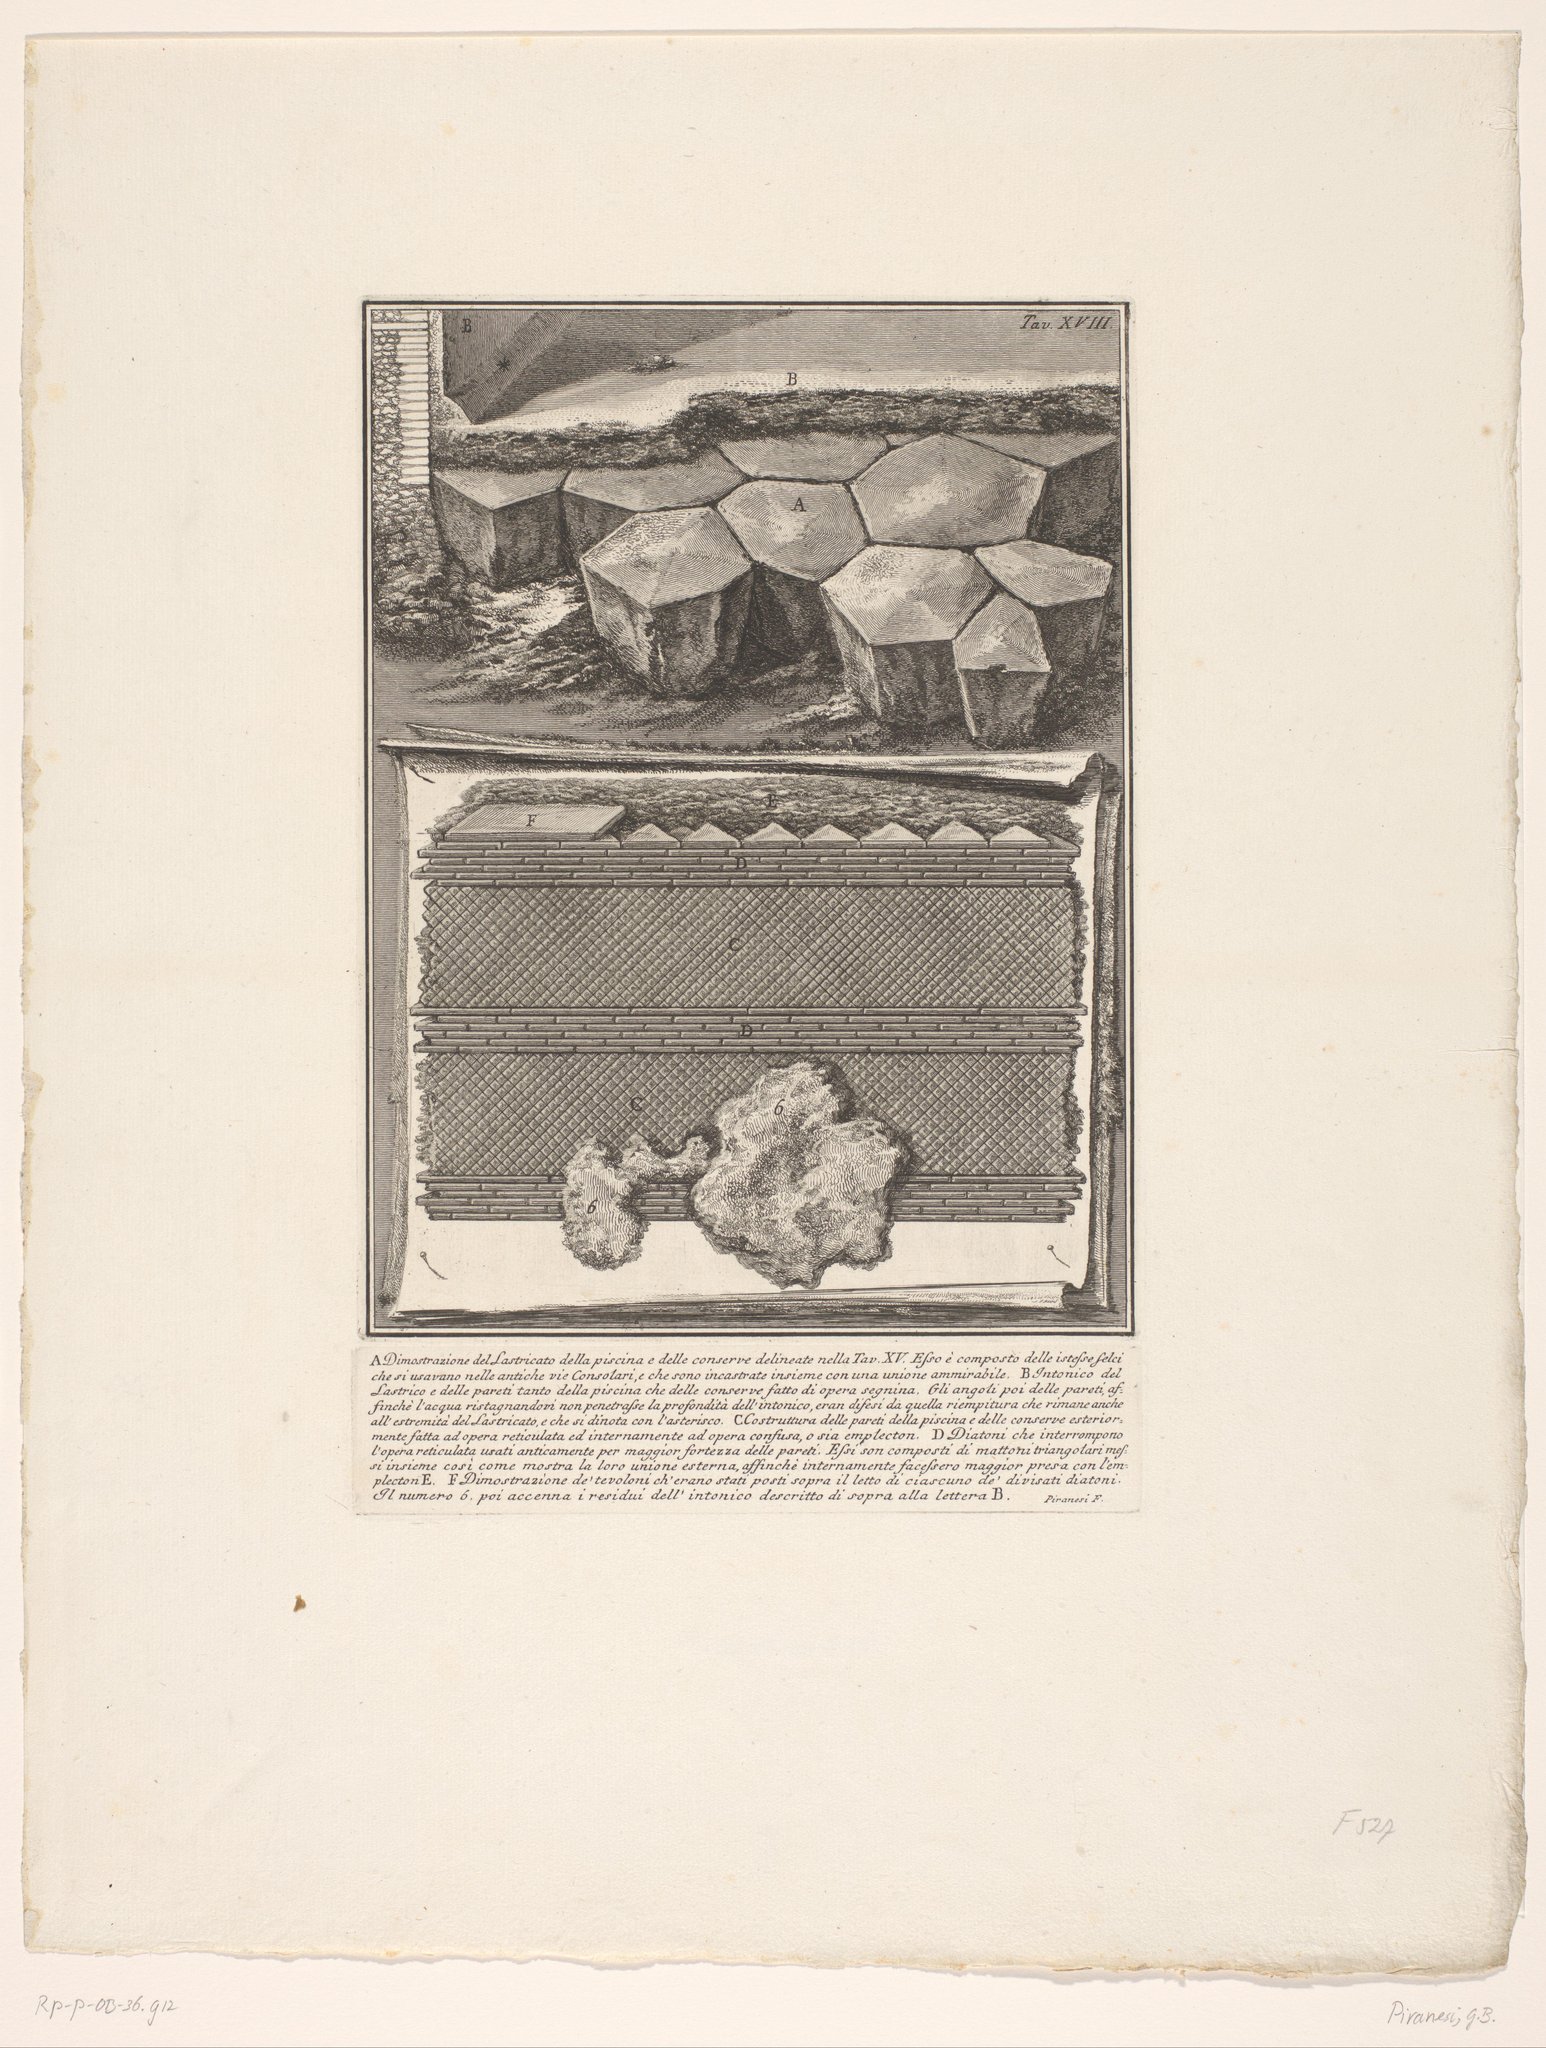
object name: print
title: Antichità d'Albano e di Castel Gandolfo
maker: giovanni battista piranesi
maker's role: designer, draughtsman, print maker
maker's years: 1720-1778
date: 1762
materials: paper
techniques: etching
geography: rome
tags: cave, grotto, boulder, stone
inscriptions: collector's mark: Lugt 2228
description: Detail en doorsnede van de vloer van een ondergronds waterreservoir in de Albaanse Heuvels. Genummerd rechtsboven: XVIII. Onder een verklarende lijst met letters gedrukt van een andere plaat.